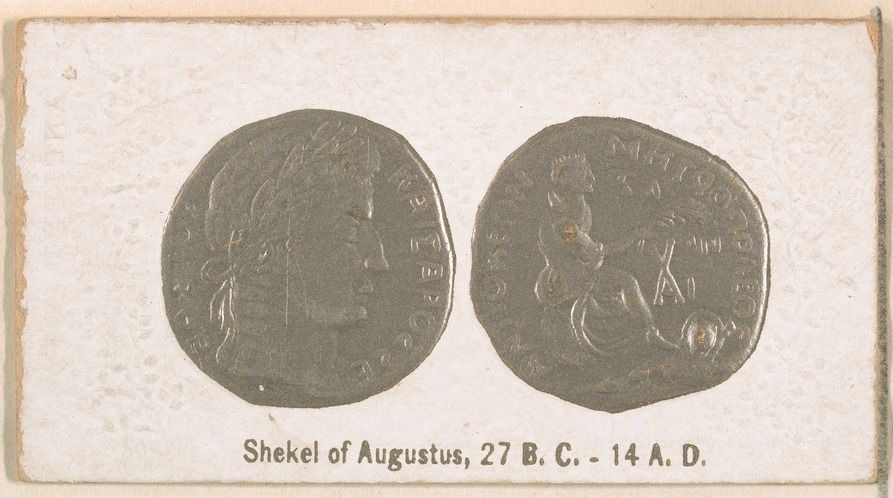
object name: print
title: Shekel of Augustus, 27 B.C.-14 A.D., from the Ancient Coins series (N180) issued by Wm. S. Kimball & Co.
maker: william s. kimball & company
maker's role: publisher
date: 1888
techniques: color lithograph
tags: men,coins